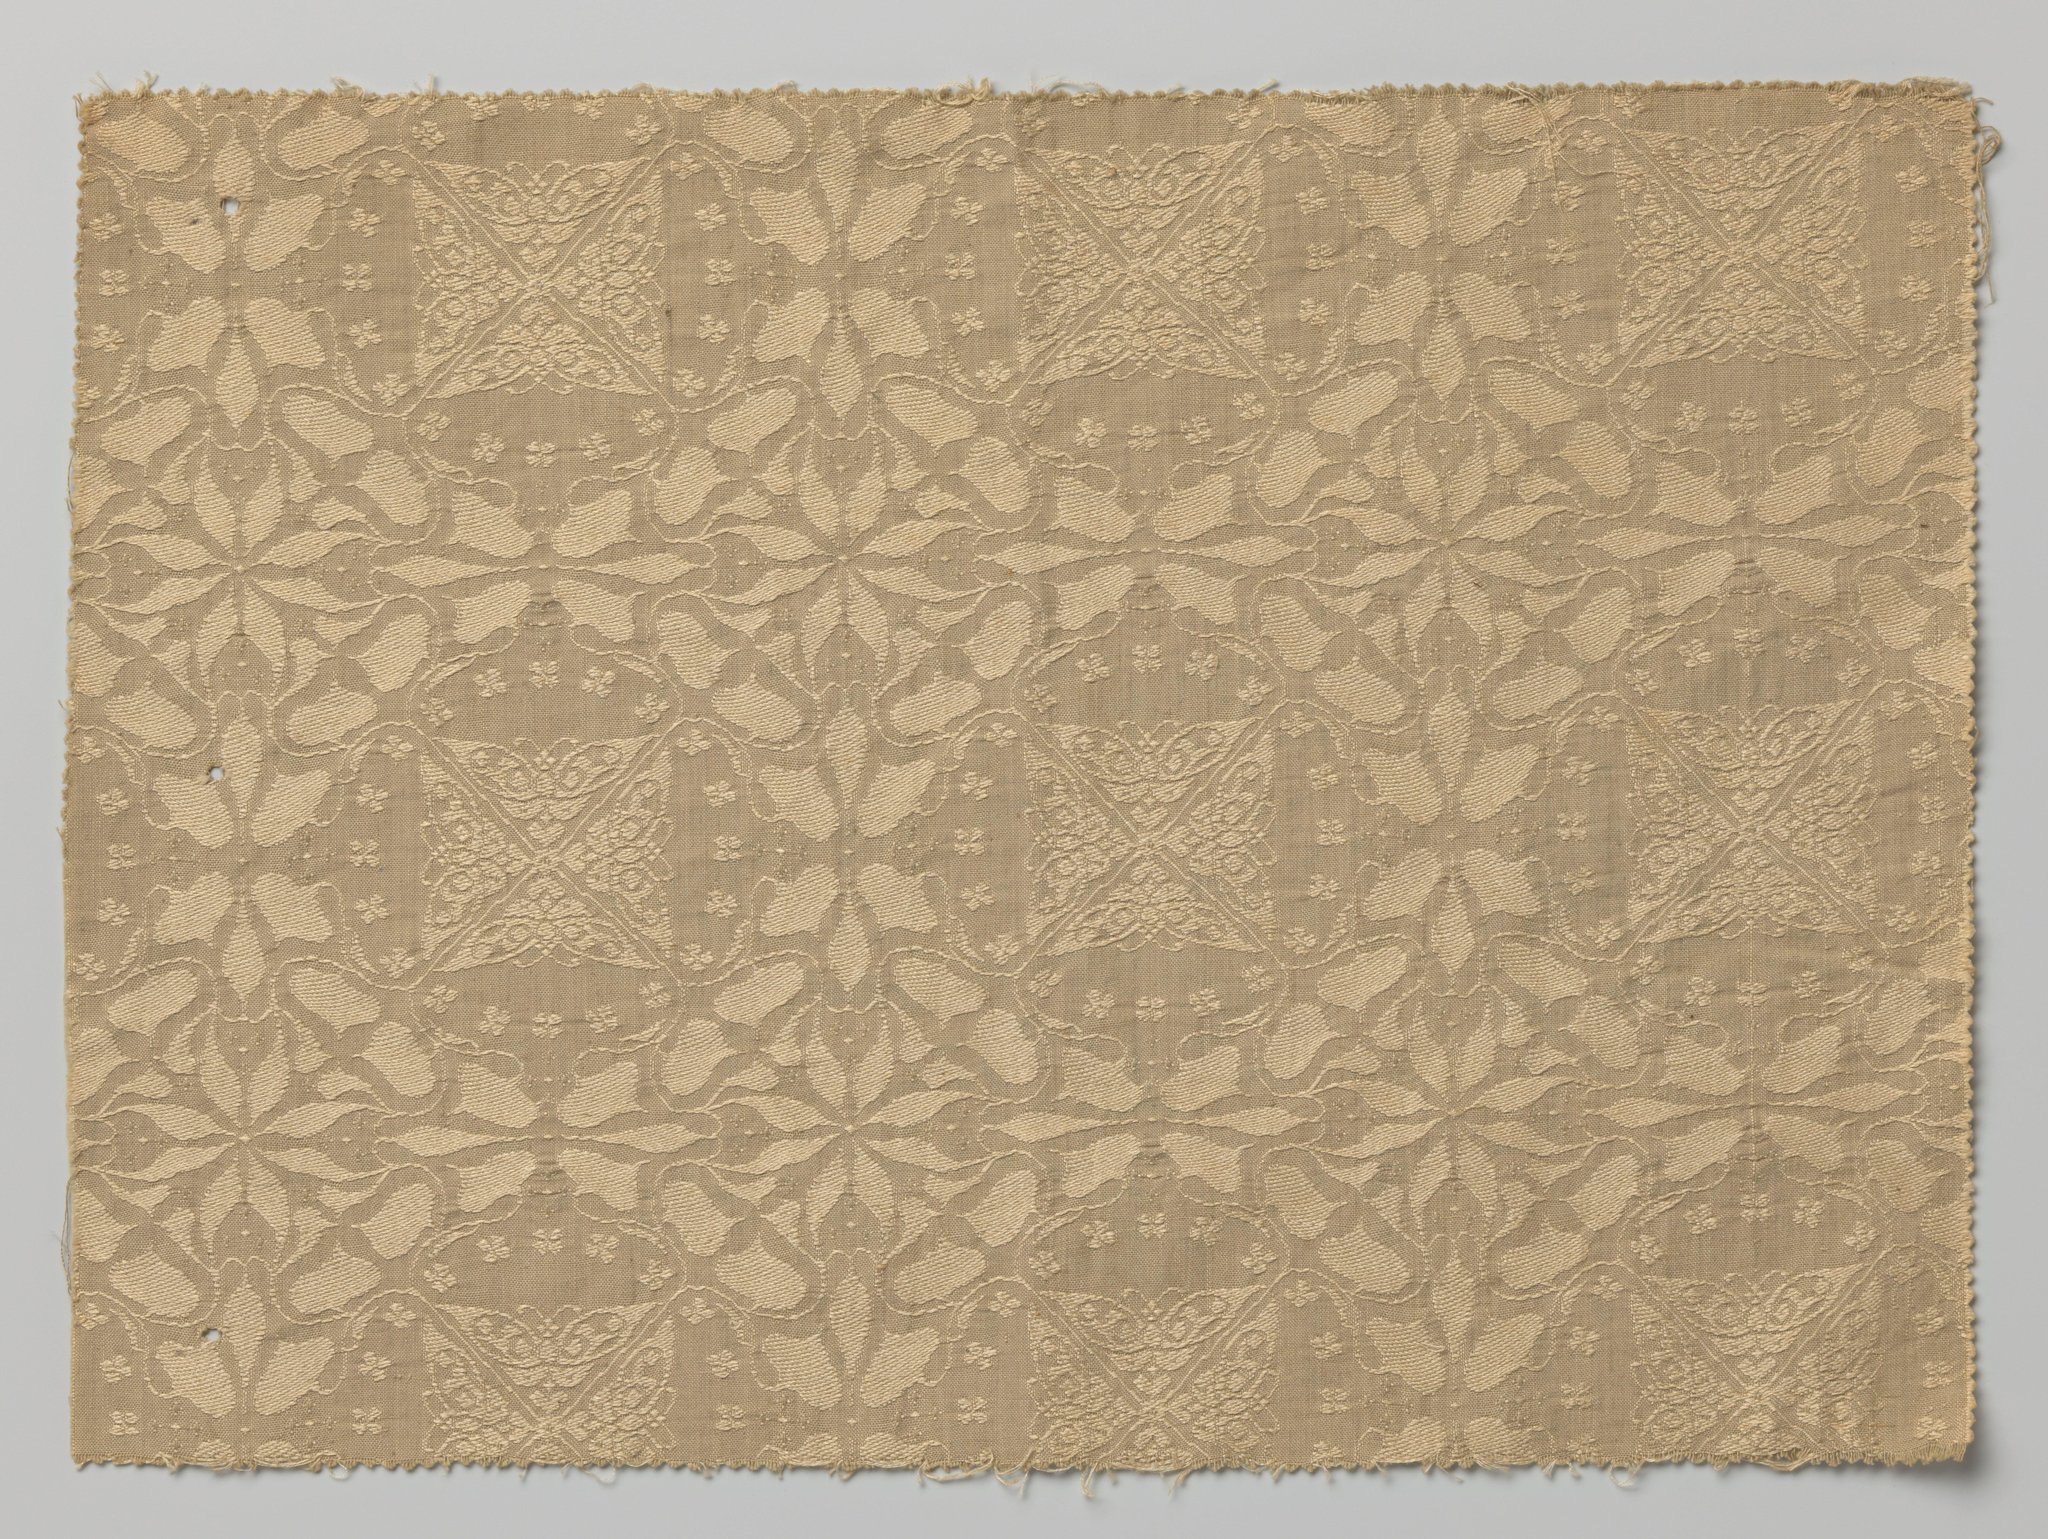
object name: upholstered wall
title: Bespanningsstof met patroon van bladeren en vlinders spitsovale banden van blaadjes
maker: theo nieuwenhuis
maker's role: designer, draughtsman, print maker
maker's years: 1866-1951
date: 1909-1924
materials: cotton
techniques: jacquard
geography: netherlands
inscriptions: number: ‘112’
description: Bespanningsstof met patroon van bladeren en vlinders. Beige inslag op grijze ketting.